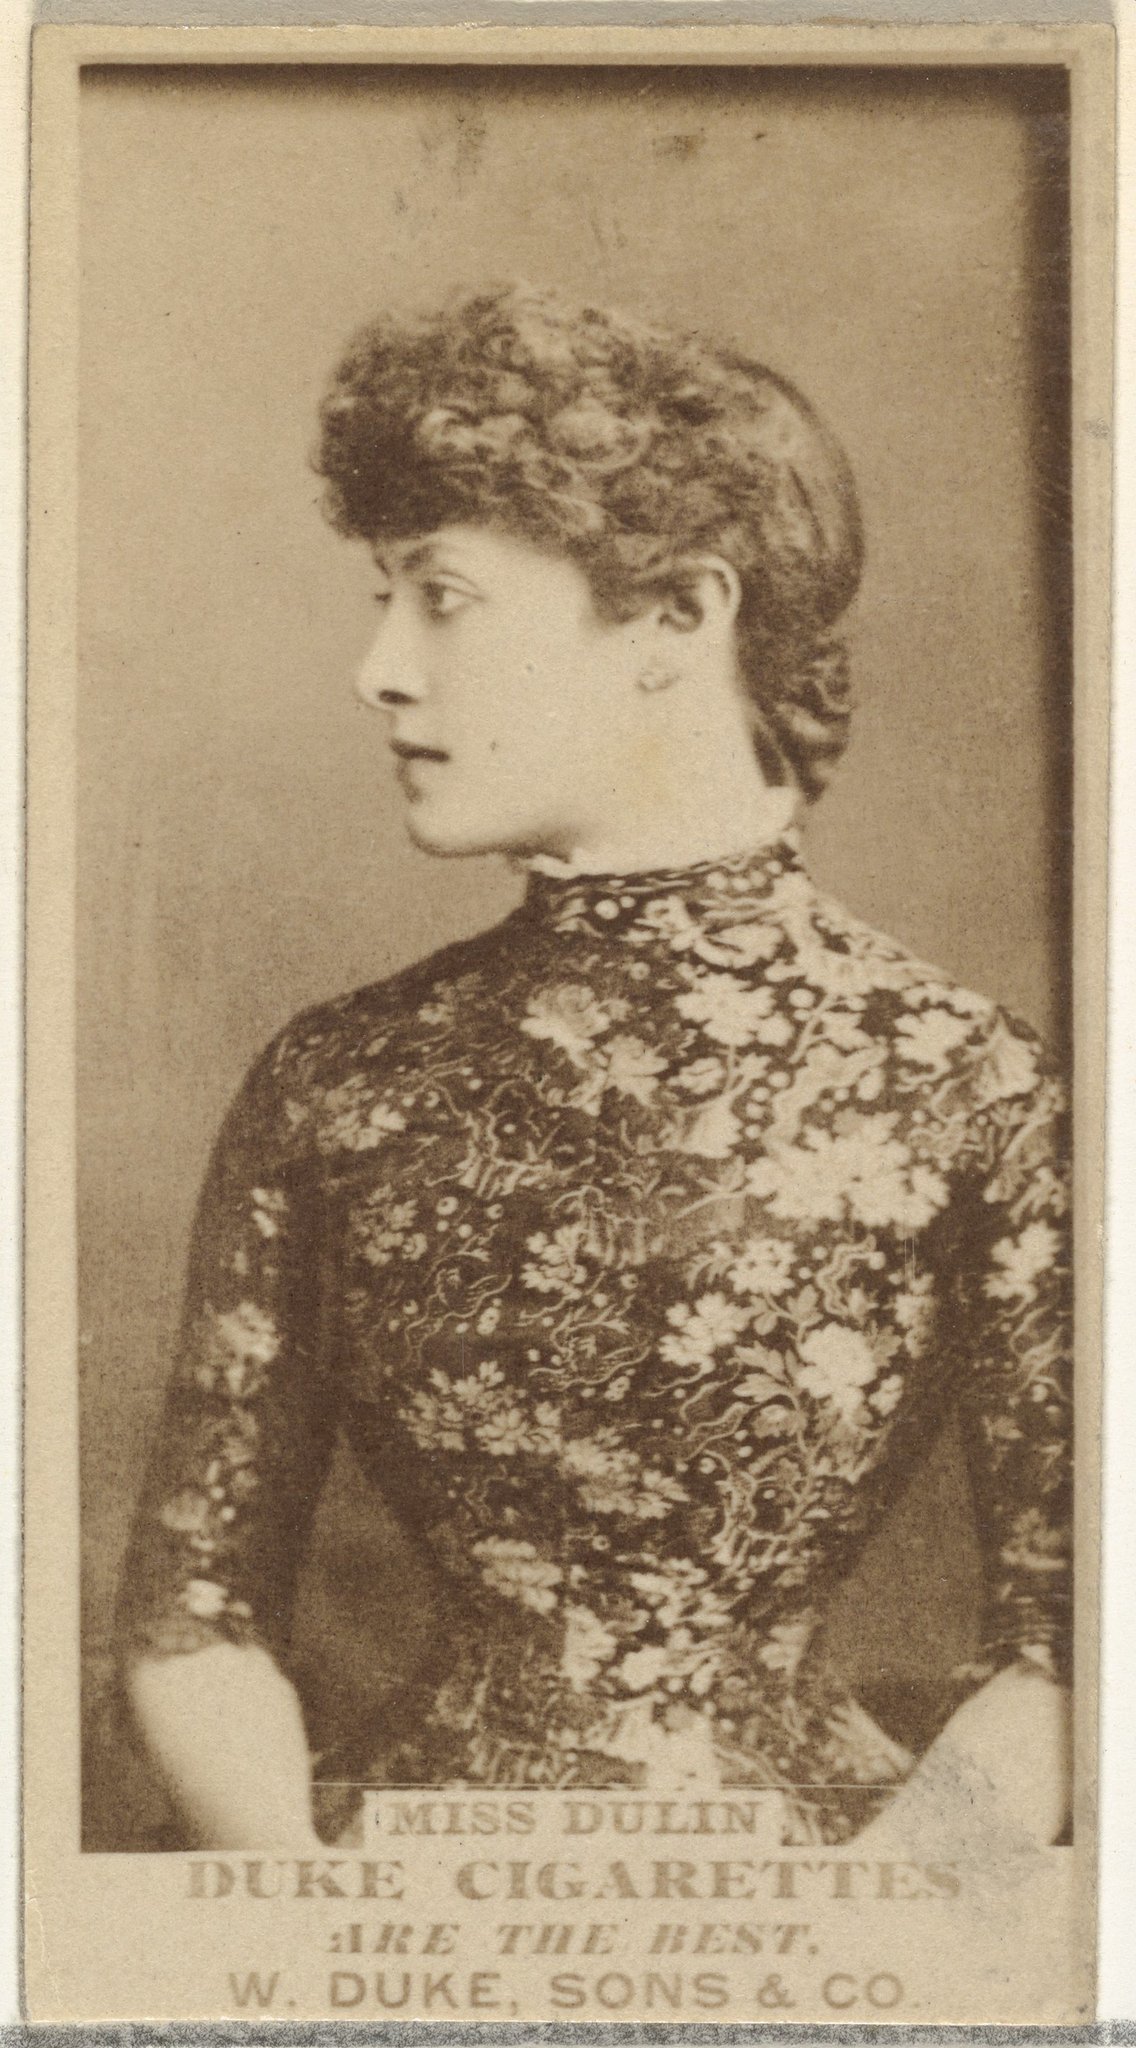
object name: photograph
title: Miss Dulin, from the Actors and Actresses series (N145-7) issued by Duke Sons & Co. to promote Duke Cigarettes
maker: w. duke, sons & co.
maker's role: publisher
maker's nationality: american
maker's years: 1870-1920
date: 1880-1889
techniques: albumen silver print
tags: profiles,women,actresses